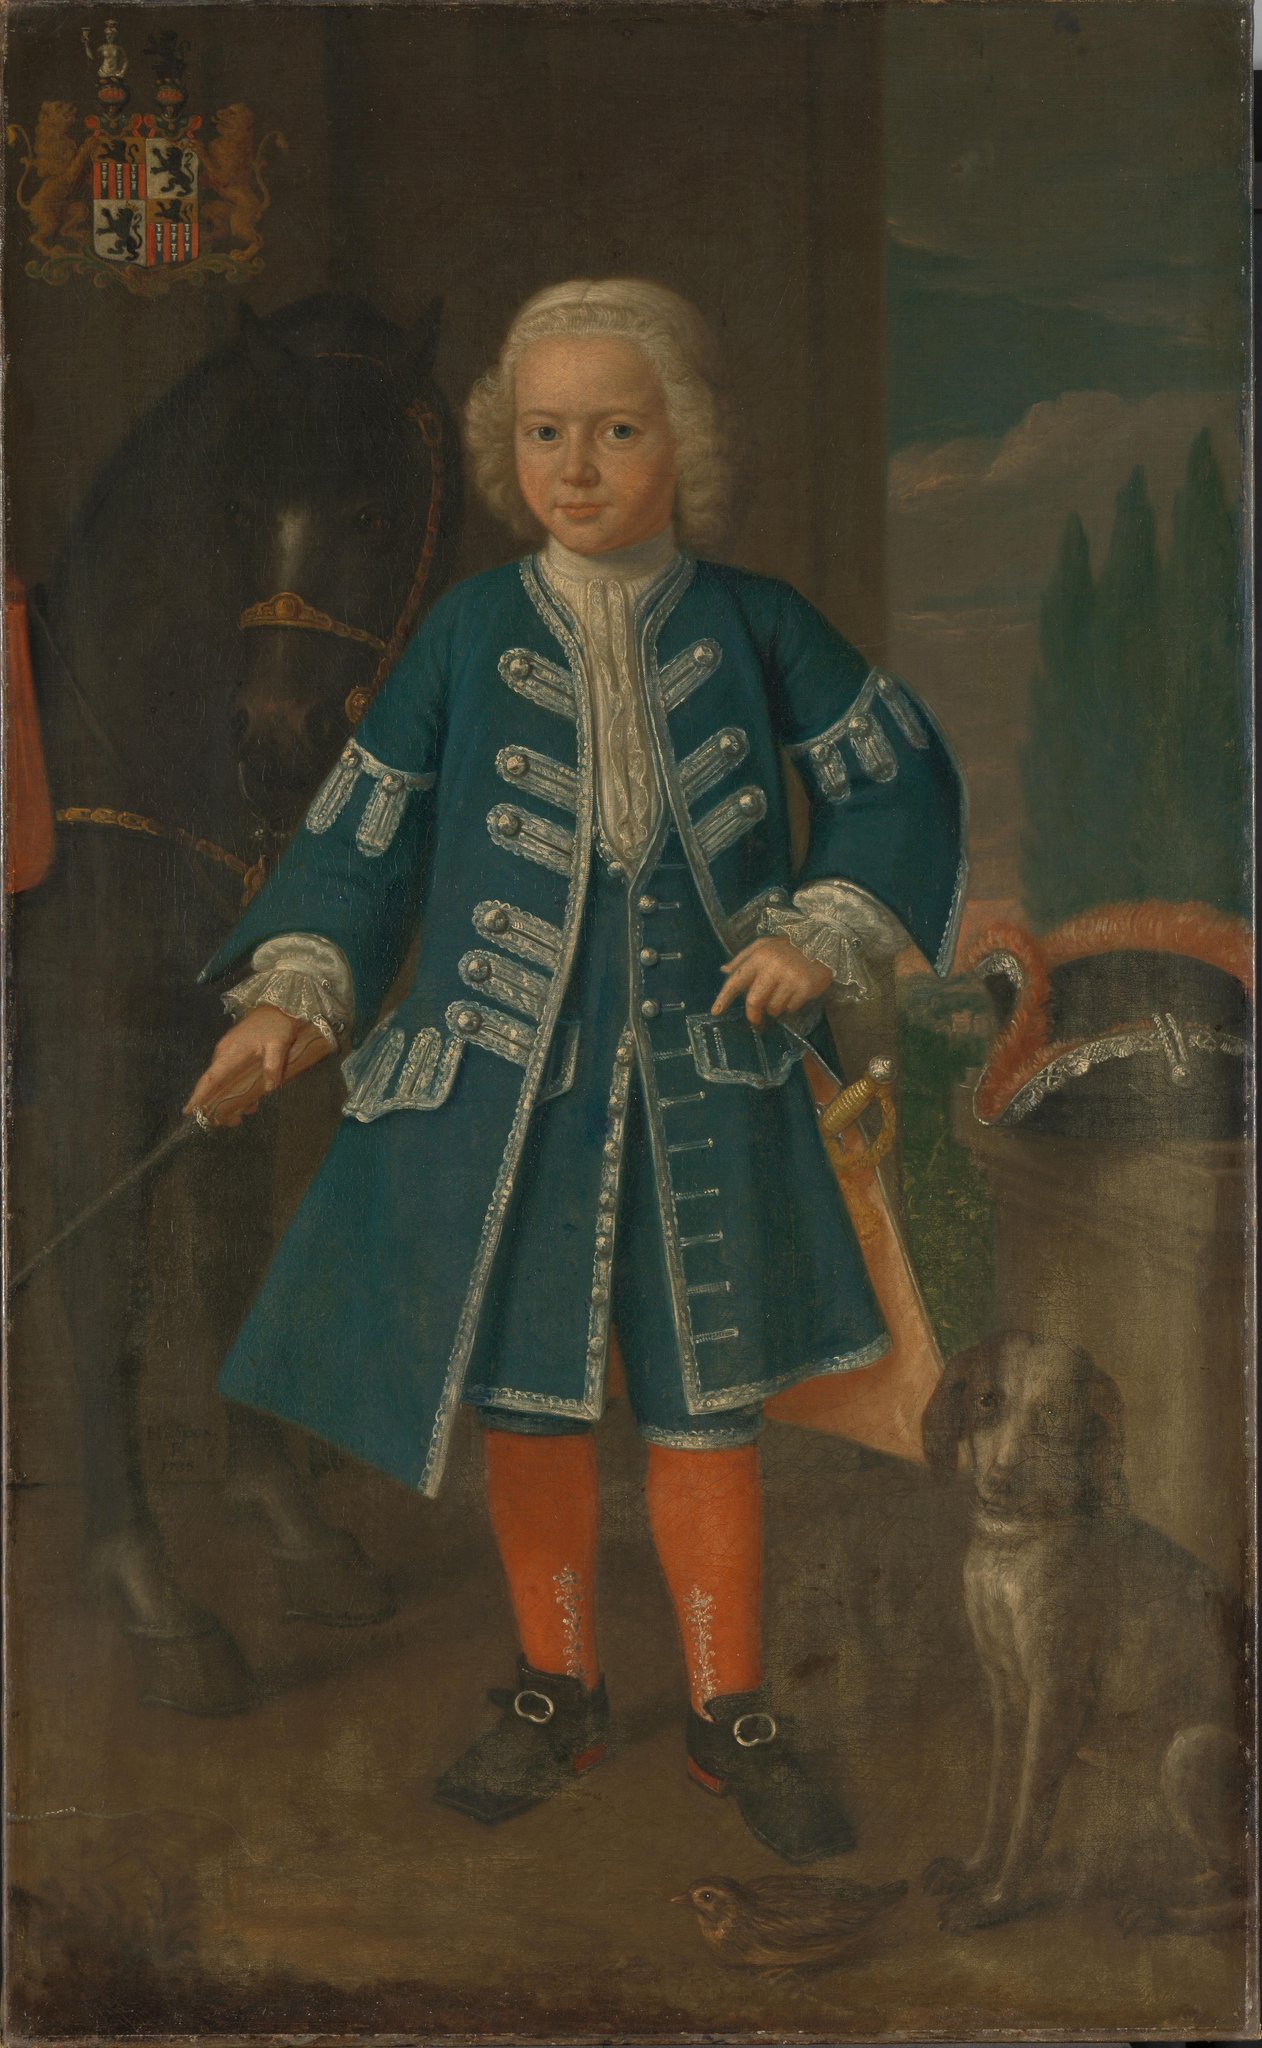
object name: painting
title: Portrait of Diederik van Hemert, Lord of Babyloniënbroek at six years of age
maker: harmanus serin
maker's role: painter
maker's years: 1677-1756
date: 1735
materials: canvas, oil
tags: boy (child between toddler and youth), historical persons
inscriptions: signature and date: ‘H. Serin F. 1735’, inscription: ‘Diederik van Heemert, Heer van Bibilonienbroek, overl. den 23 April 1753. Wiens wapen hangt te Meeuwen in de kerk.’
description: Portret van Diederik van Hemert (1729-53), heer van Babiloniënbroek op zesjarige leeftijd. Staande, ten voeten uit, in een blauw uniform, op een terras naast zijn paard en hond, in de rechterhand een zweep. Op de balustrade ligt zijn steek, op de voorgrond een vogel. Linksboven het familiewapen.